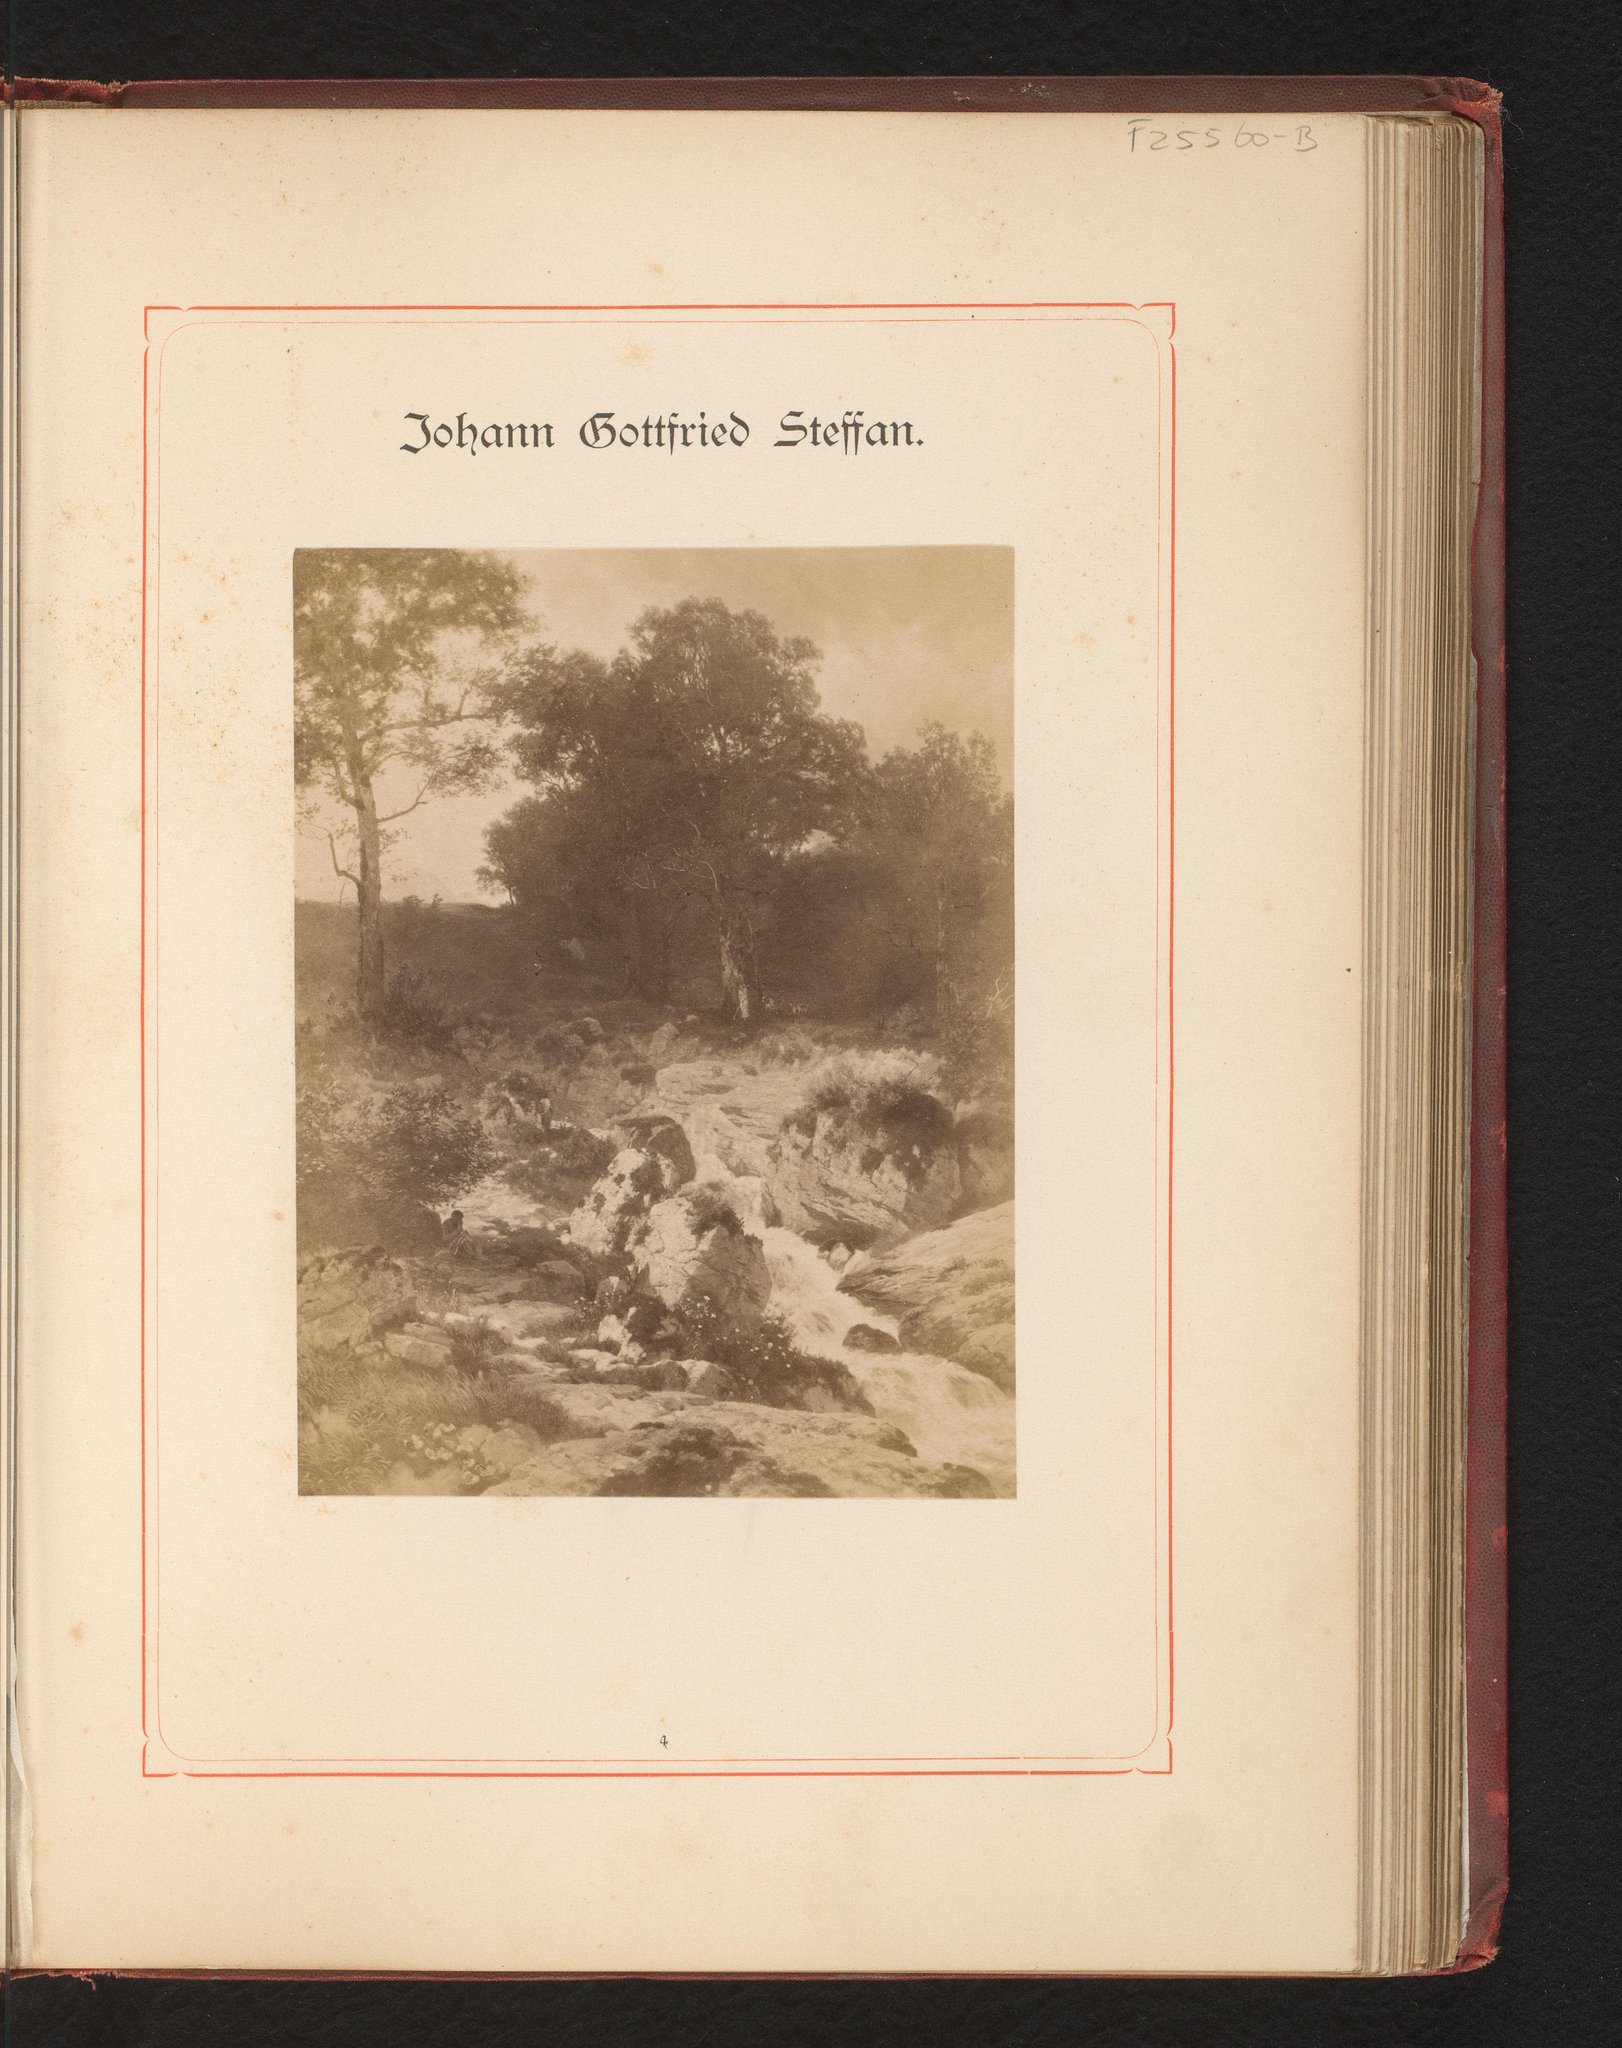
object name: photograph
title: Fotoreproductie van schilderij van een waterval door Johann Gottfried Steffan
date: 1870-1890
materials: paper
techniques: albumen print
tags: waterfall, picture, painting